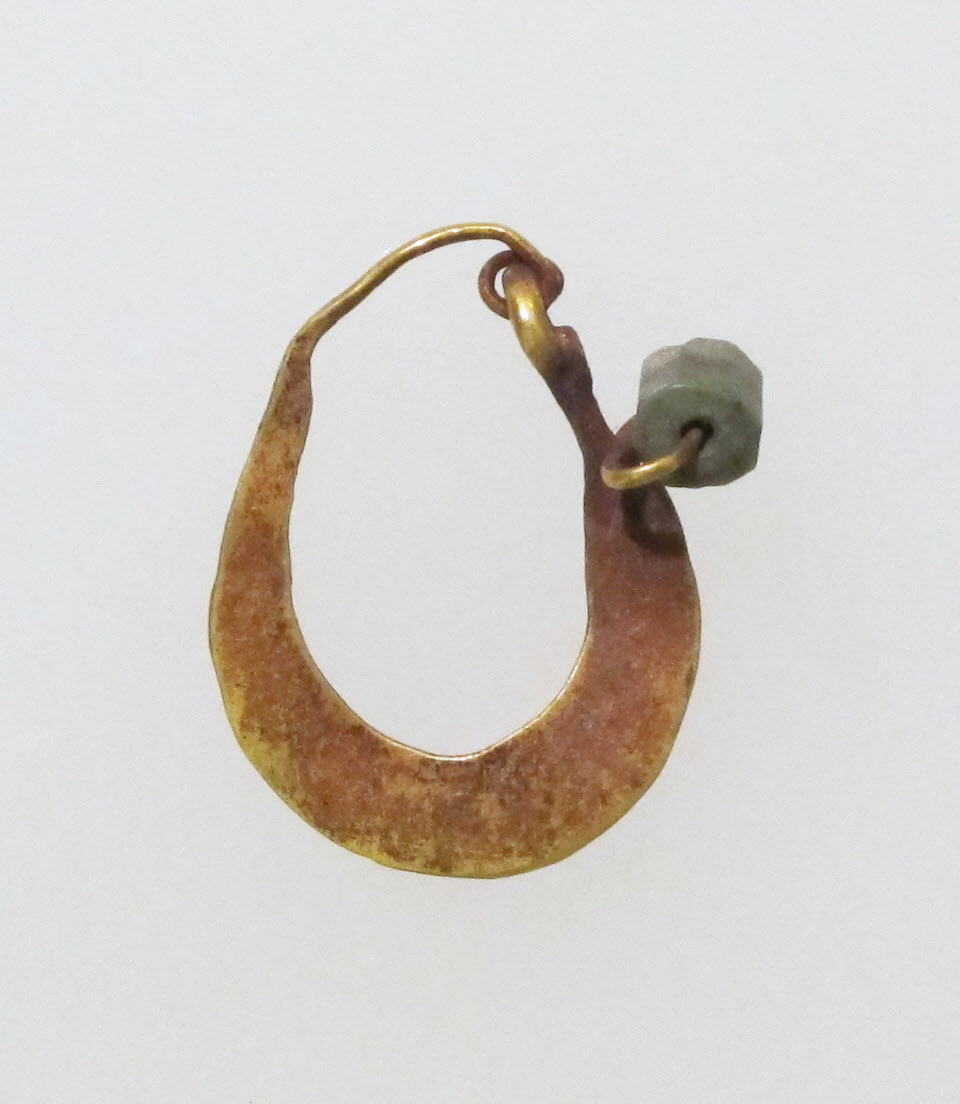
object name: earring, crescent shaped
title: Earring, crescent-shaped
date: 7000 BCE-330 CE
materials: gold